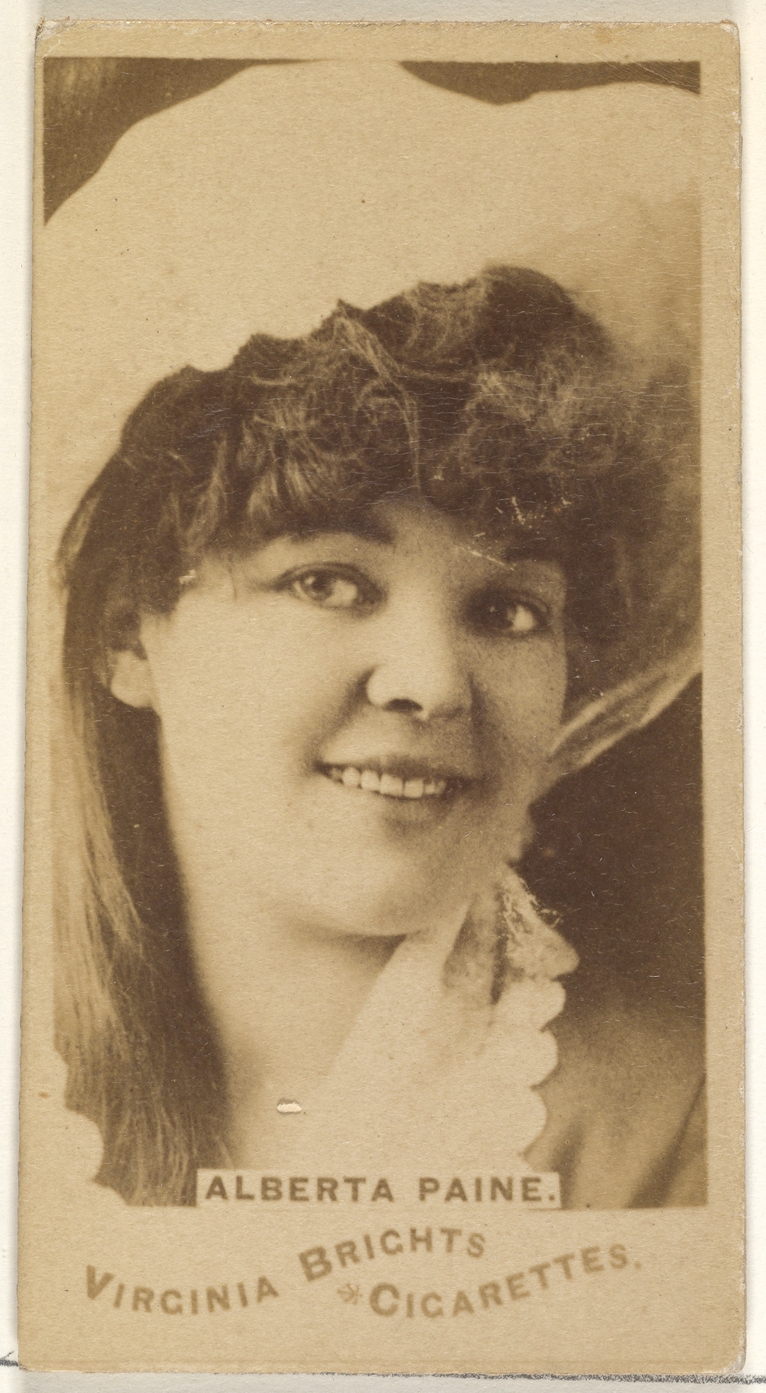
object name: photograph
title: Alberta Paine, from the Actors and Actresses series (N45, Type 1) for Virginia Brights Cigarettes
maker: allen & ginter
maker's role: publisher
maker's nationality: american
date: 1888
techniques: albumen silver print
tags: portraits,women,actresses